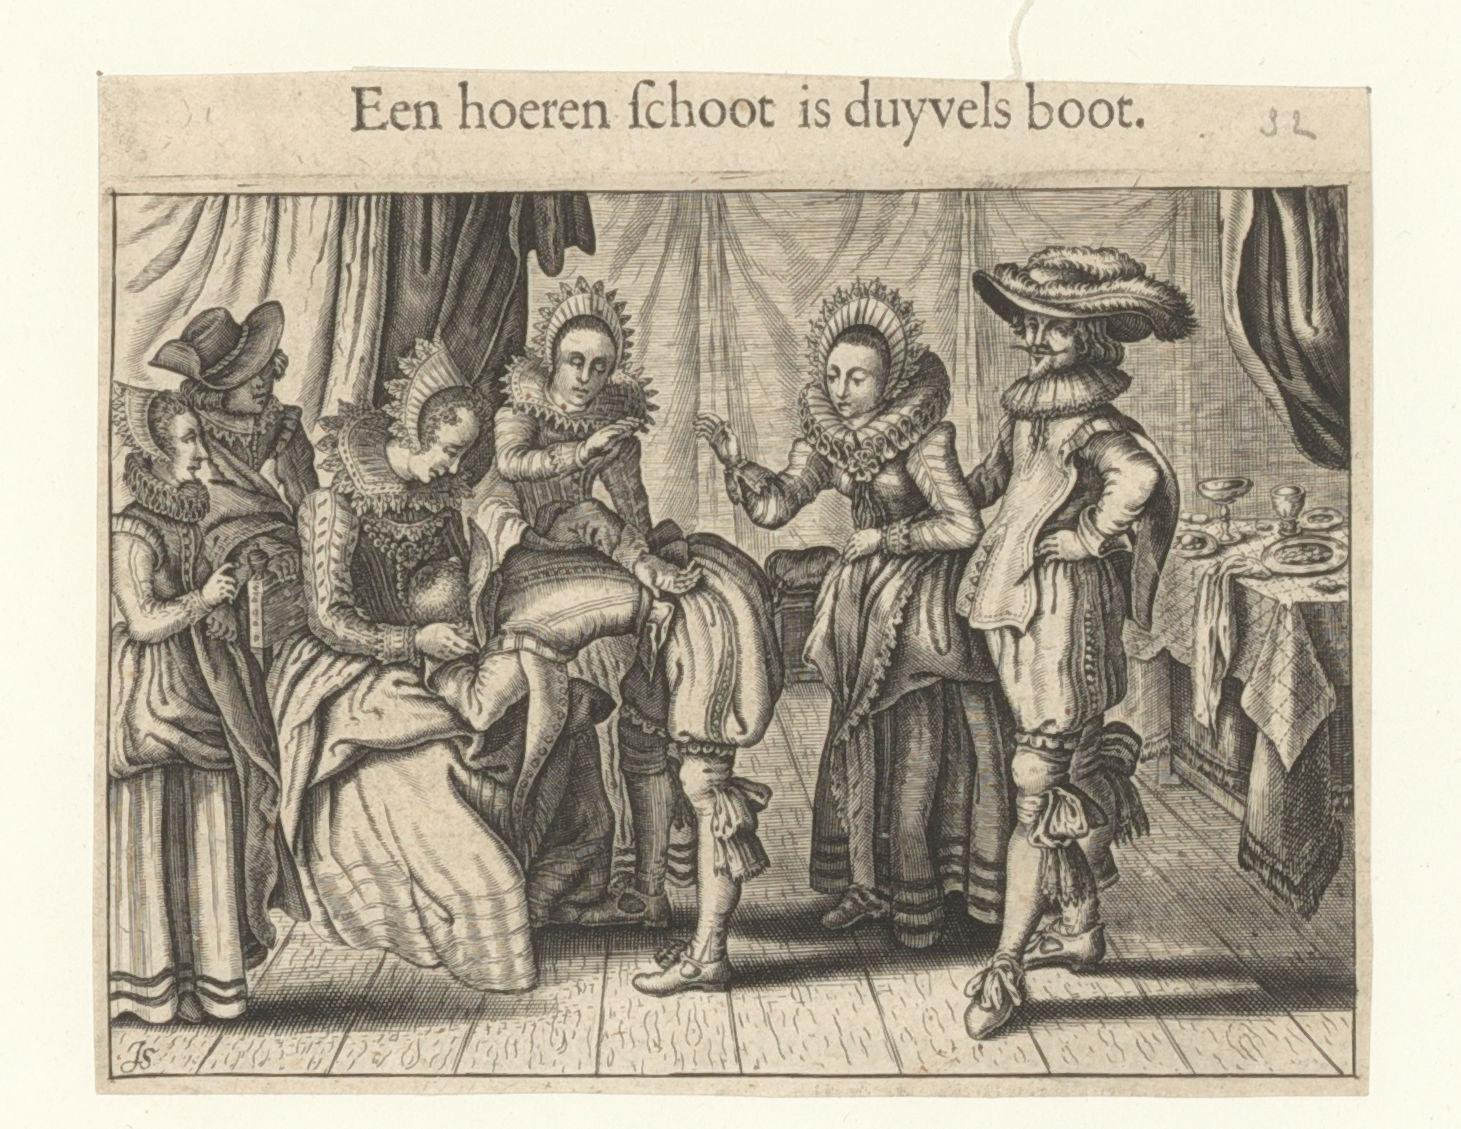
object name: print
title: Man duwt zijn gezicht in de schoot van een vrouw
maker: jan gerritsz swelinck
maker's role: print maker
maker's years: 1600-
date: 1624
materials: paper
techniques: engraving, letterpress printing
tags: adult woman, adult man, hot cockles, 'haute coquilles', 'la main chaude' (party game), proverbs, sayings, etc., vice, evil, sin; 'peccato' (ripa), loose company, amorousness, desire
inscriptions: collector's mark: Lugt 1641, stamp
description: Prent uit: Brune, Johan de. Zinne-werck, Voor-ghesyelt in Beelden, Ghedichten, ende breeder uyt-legginghen (...). Amsterdam: Evertsen Kloppenburch, 1624. Prent ook gebruikt in latere edities (1636 en 1661).